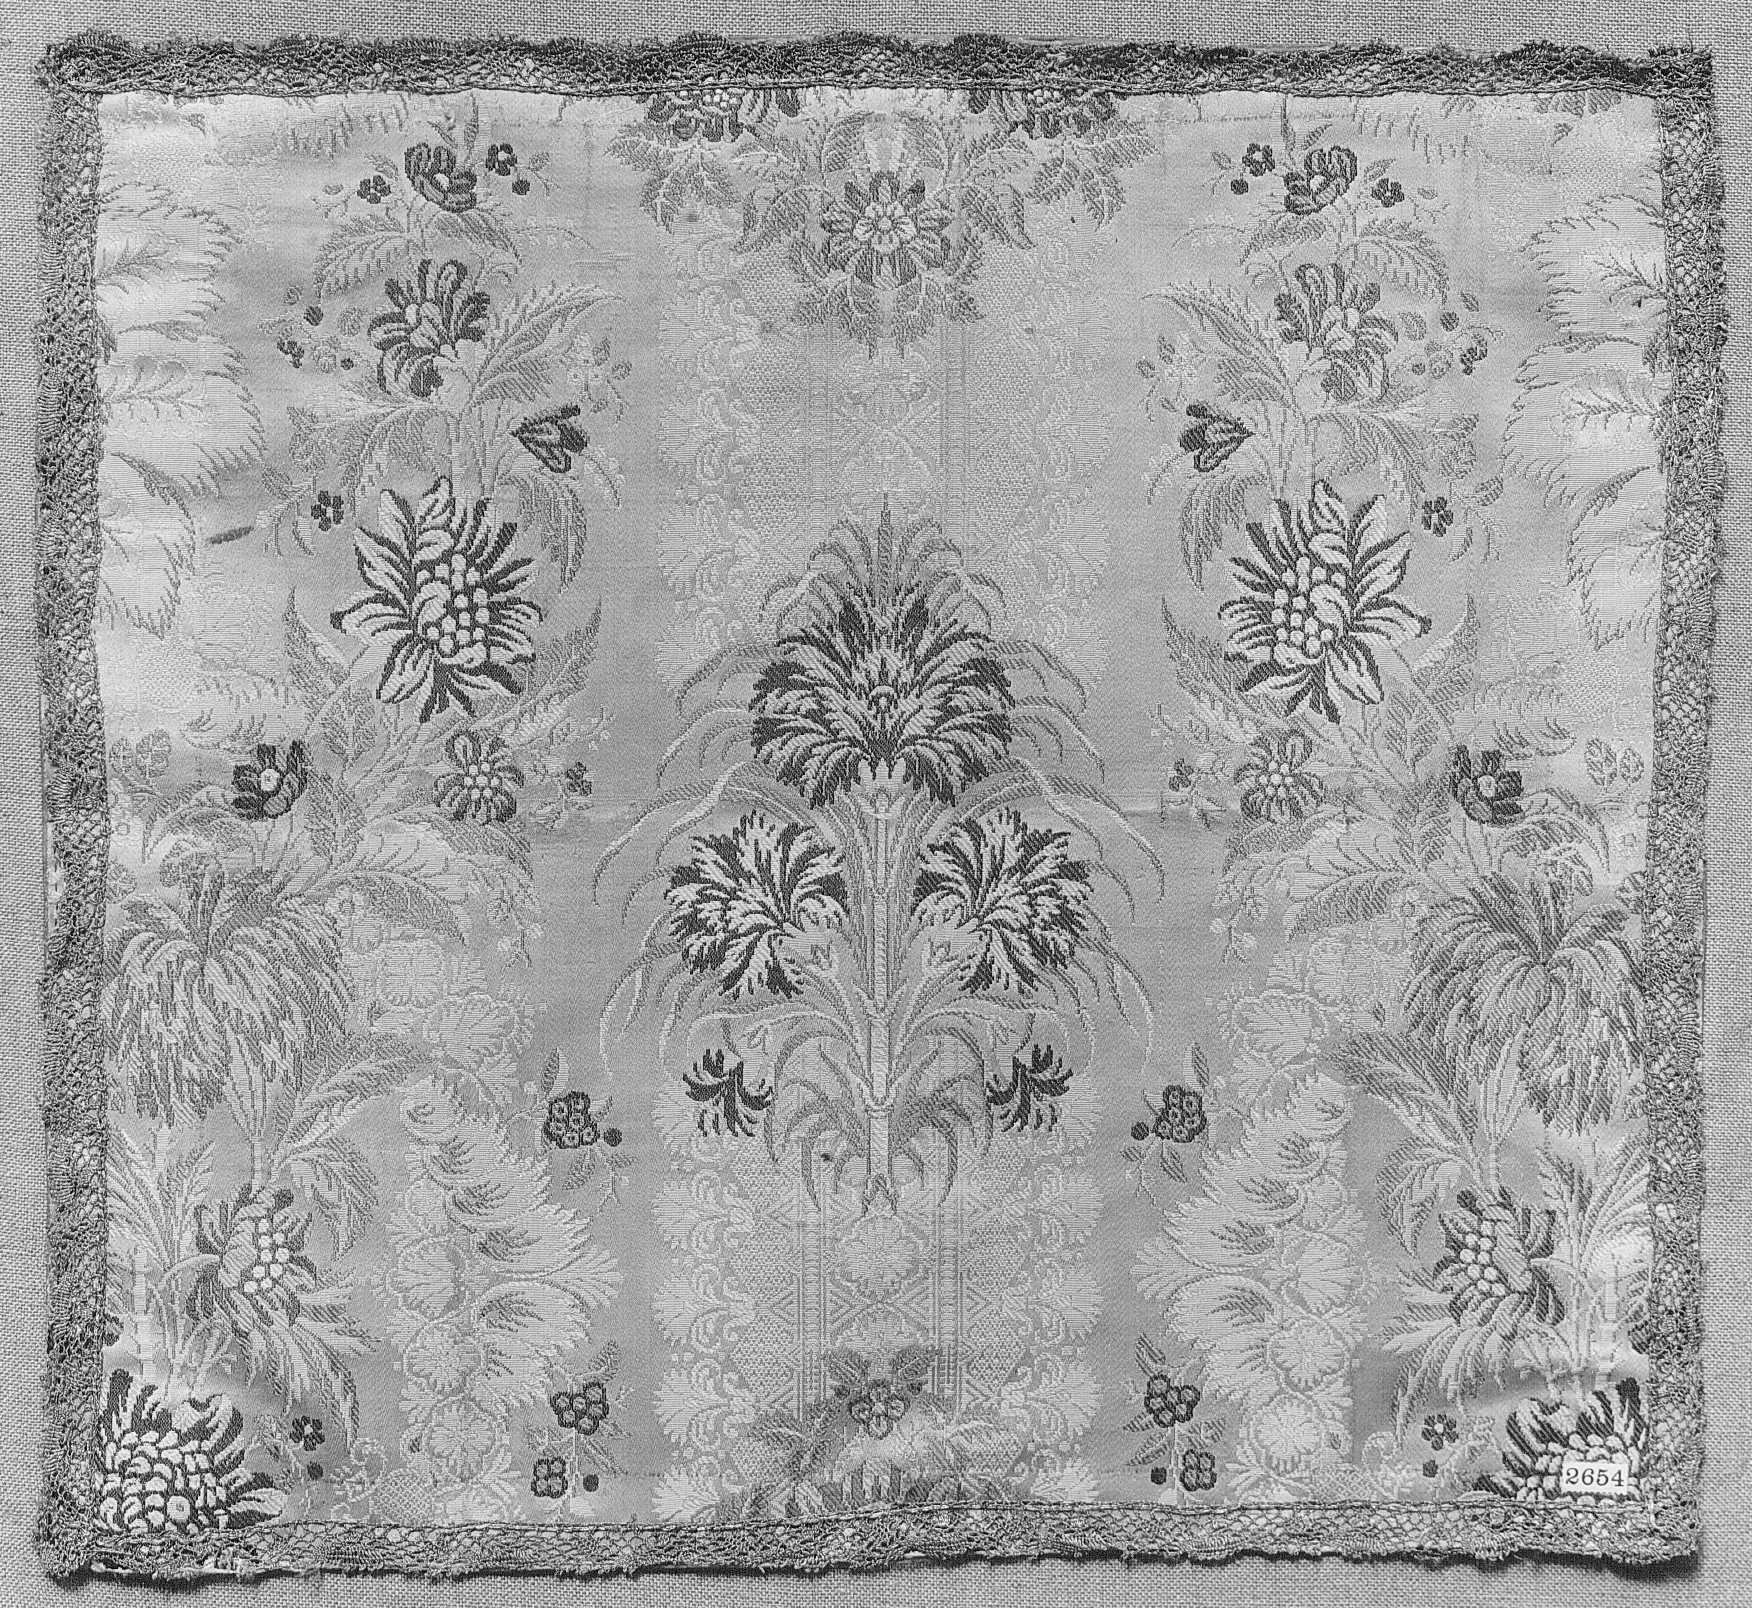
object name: piece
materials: silk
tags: flowers,leaves